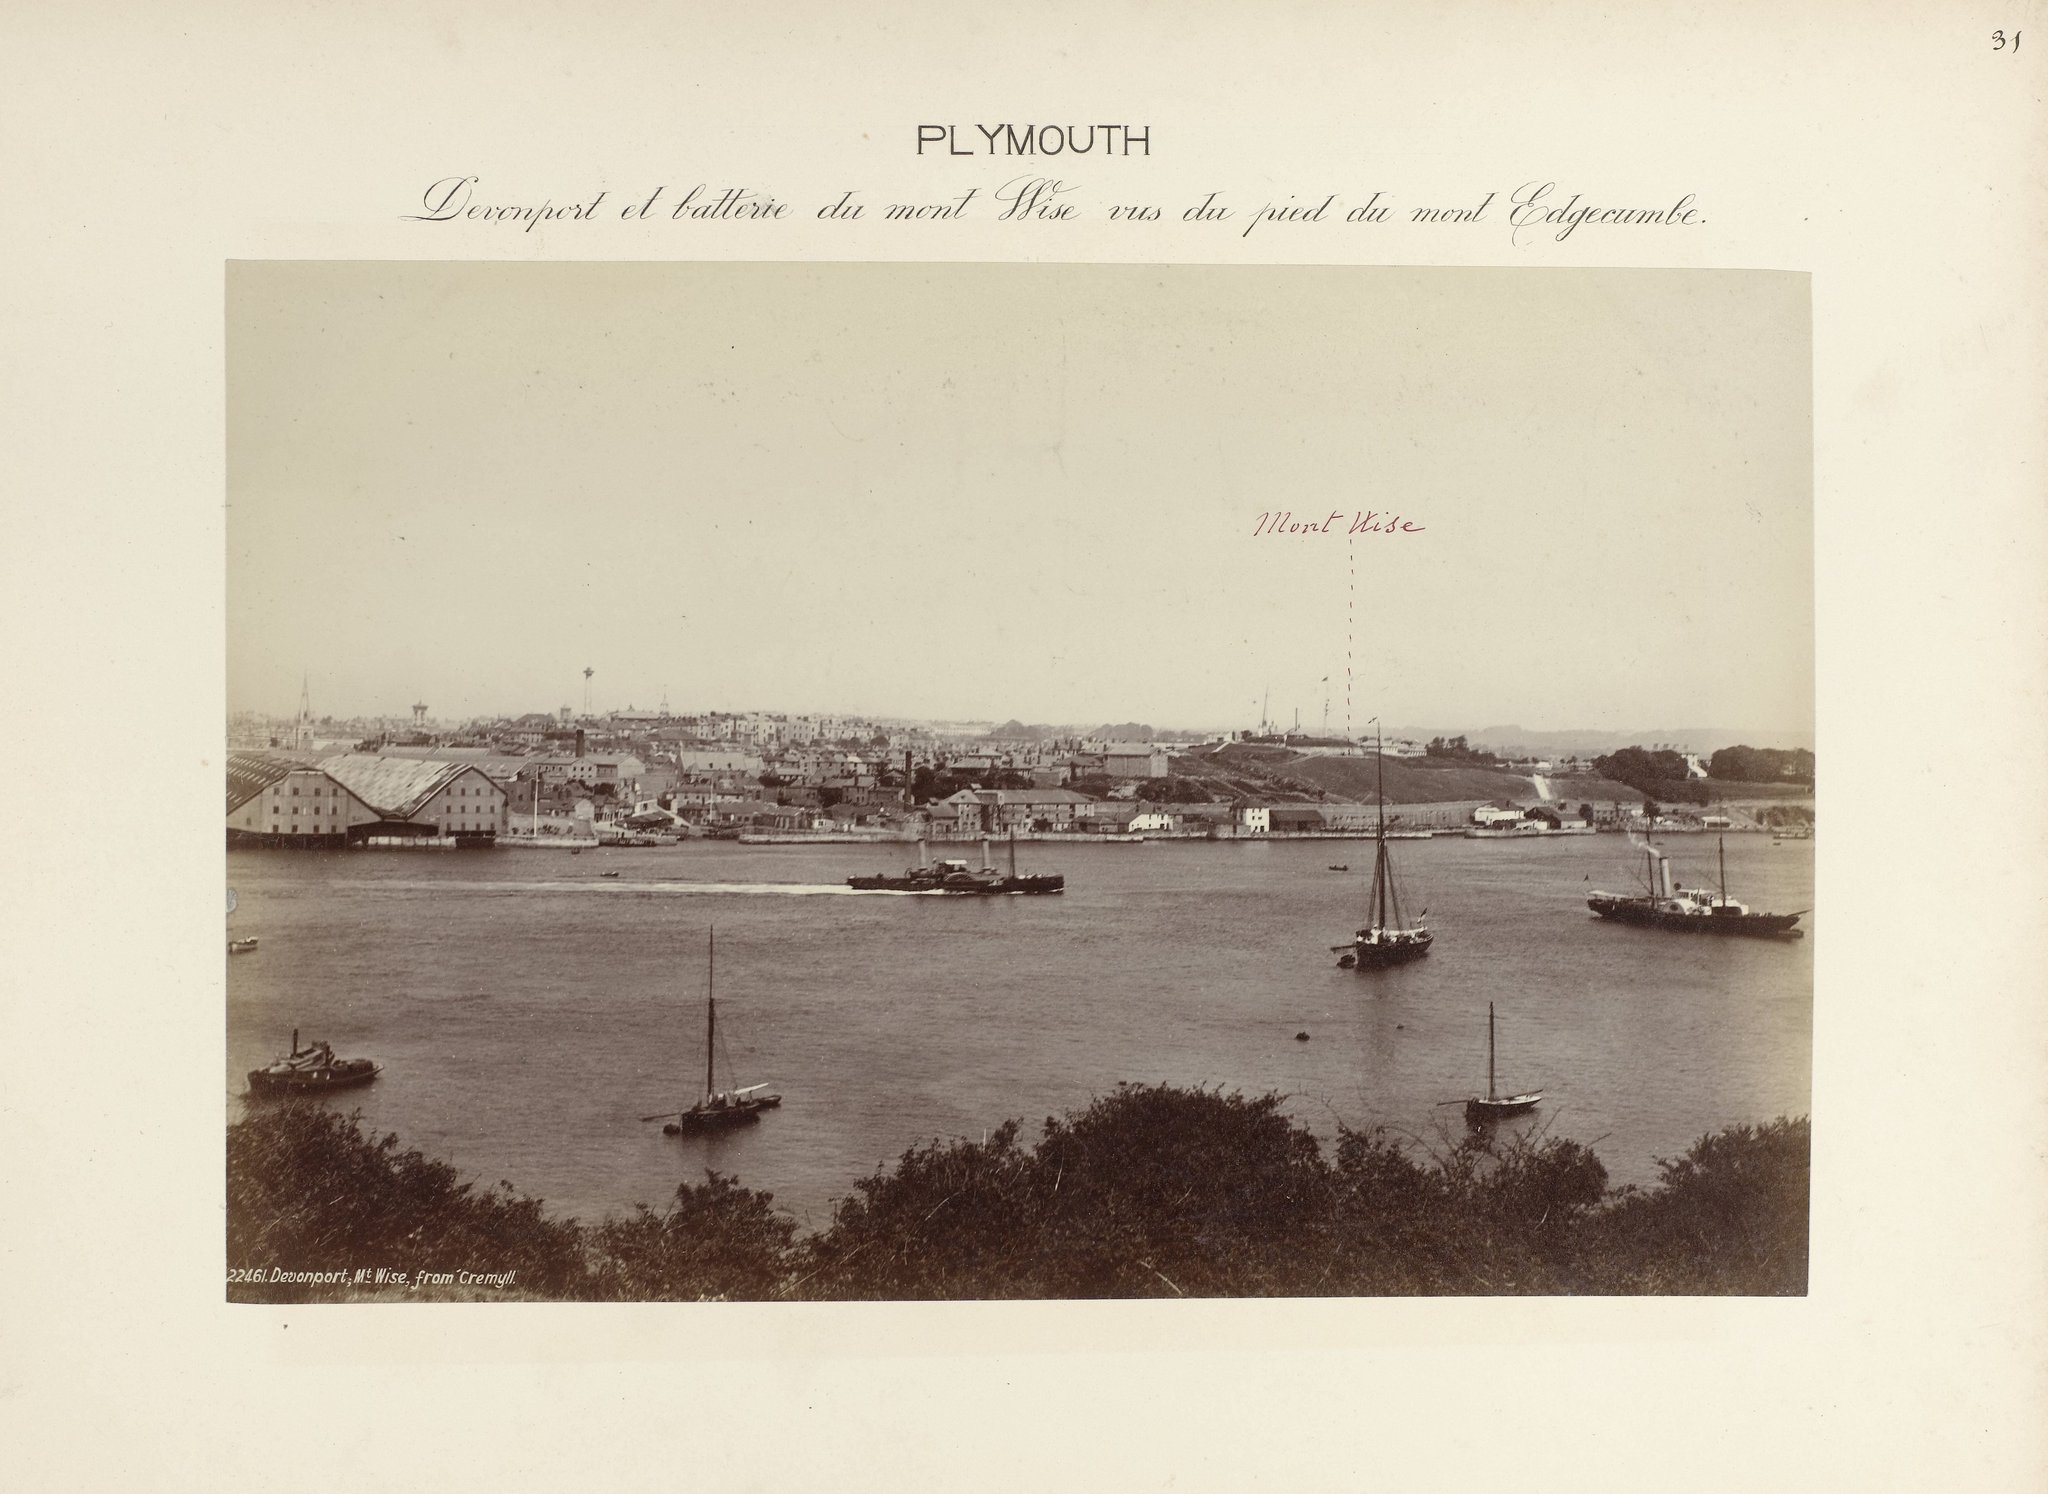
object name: photograph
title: Gezicht op Plymouth vanaf de voet van Mount Edgcumbe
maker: Anonymous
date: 1891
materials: cardboard, paper, photographic support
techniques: albumen print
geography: great britain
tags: plymouth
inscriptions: inscription: ‘PLYMOUTH / Devonport et batterie du mont Wise vus du pied du mont Edgecumbe’, inscription: ‘22461. Devonport; Mt Wise, from Cremyll.’, annotation: ‘Mont Wise’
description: Foto uit een album met 35 topografische foto's van Britse kustplaatsen, waarop in pen militaire verdedigingswerken zijn aangegeven door een Franse militair.